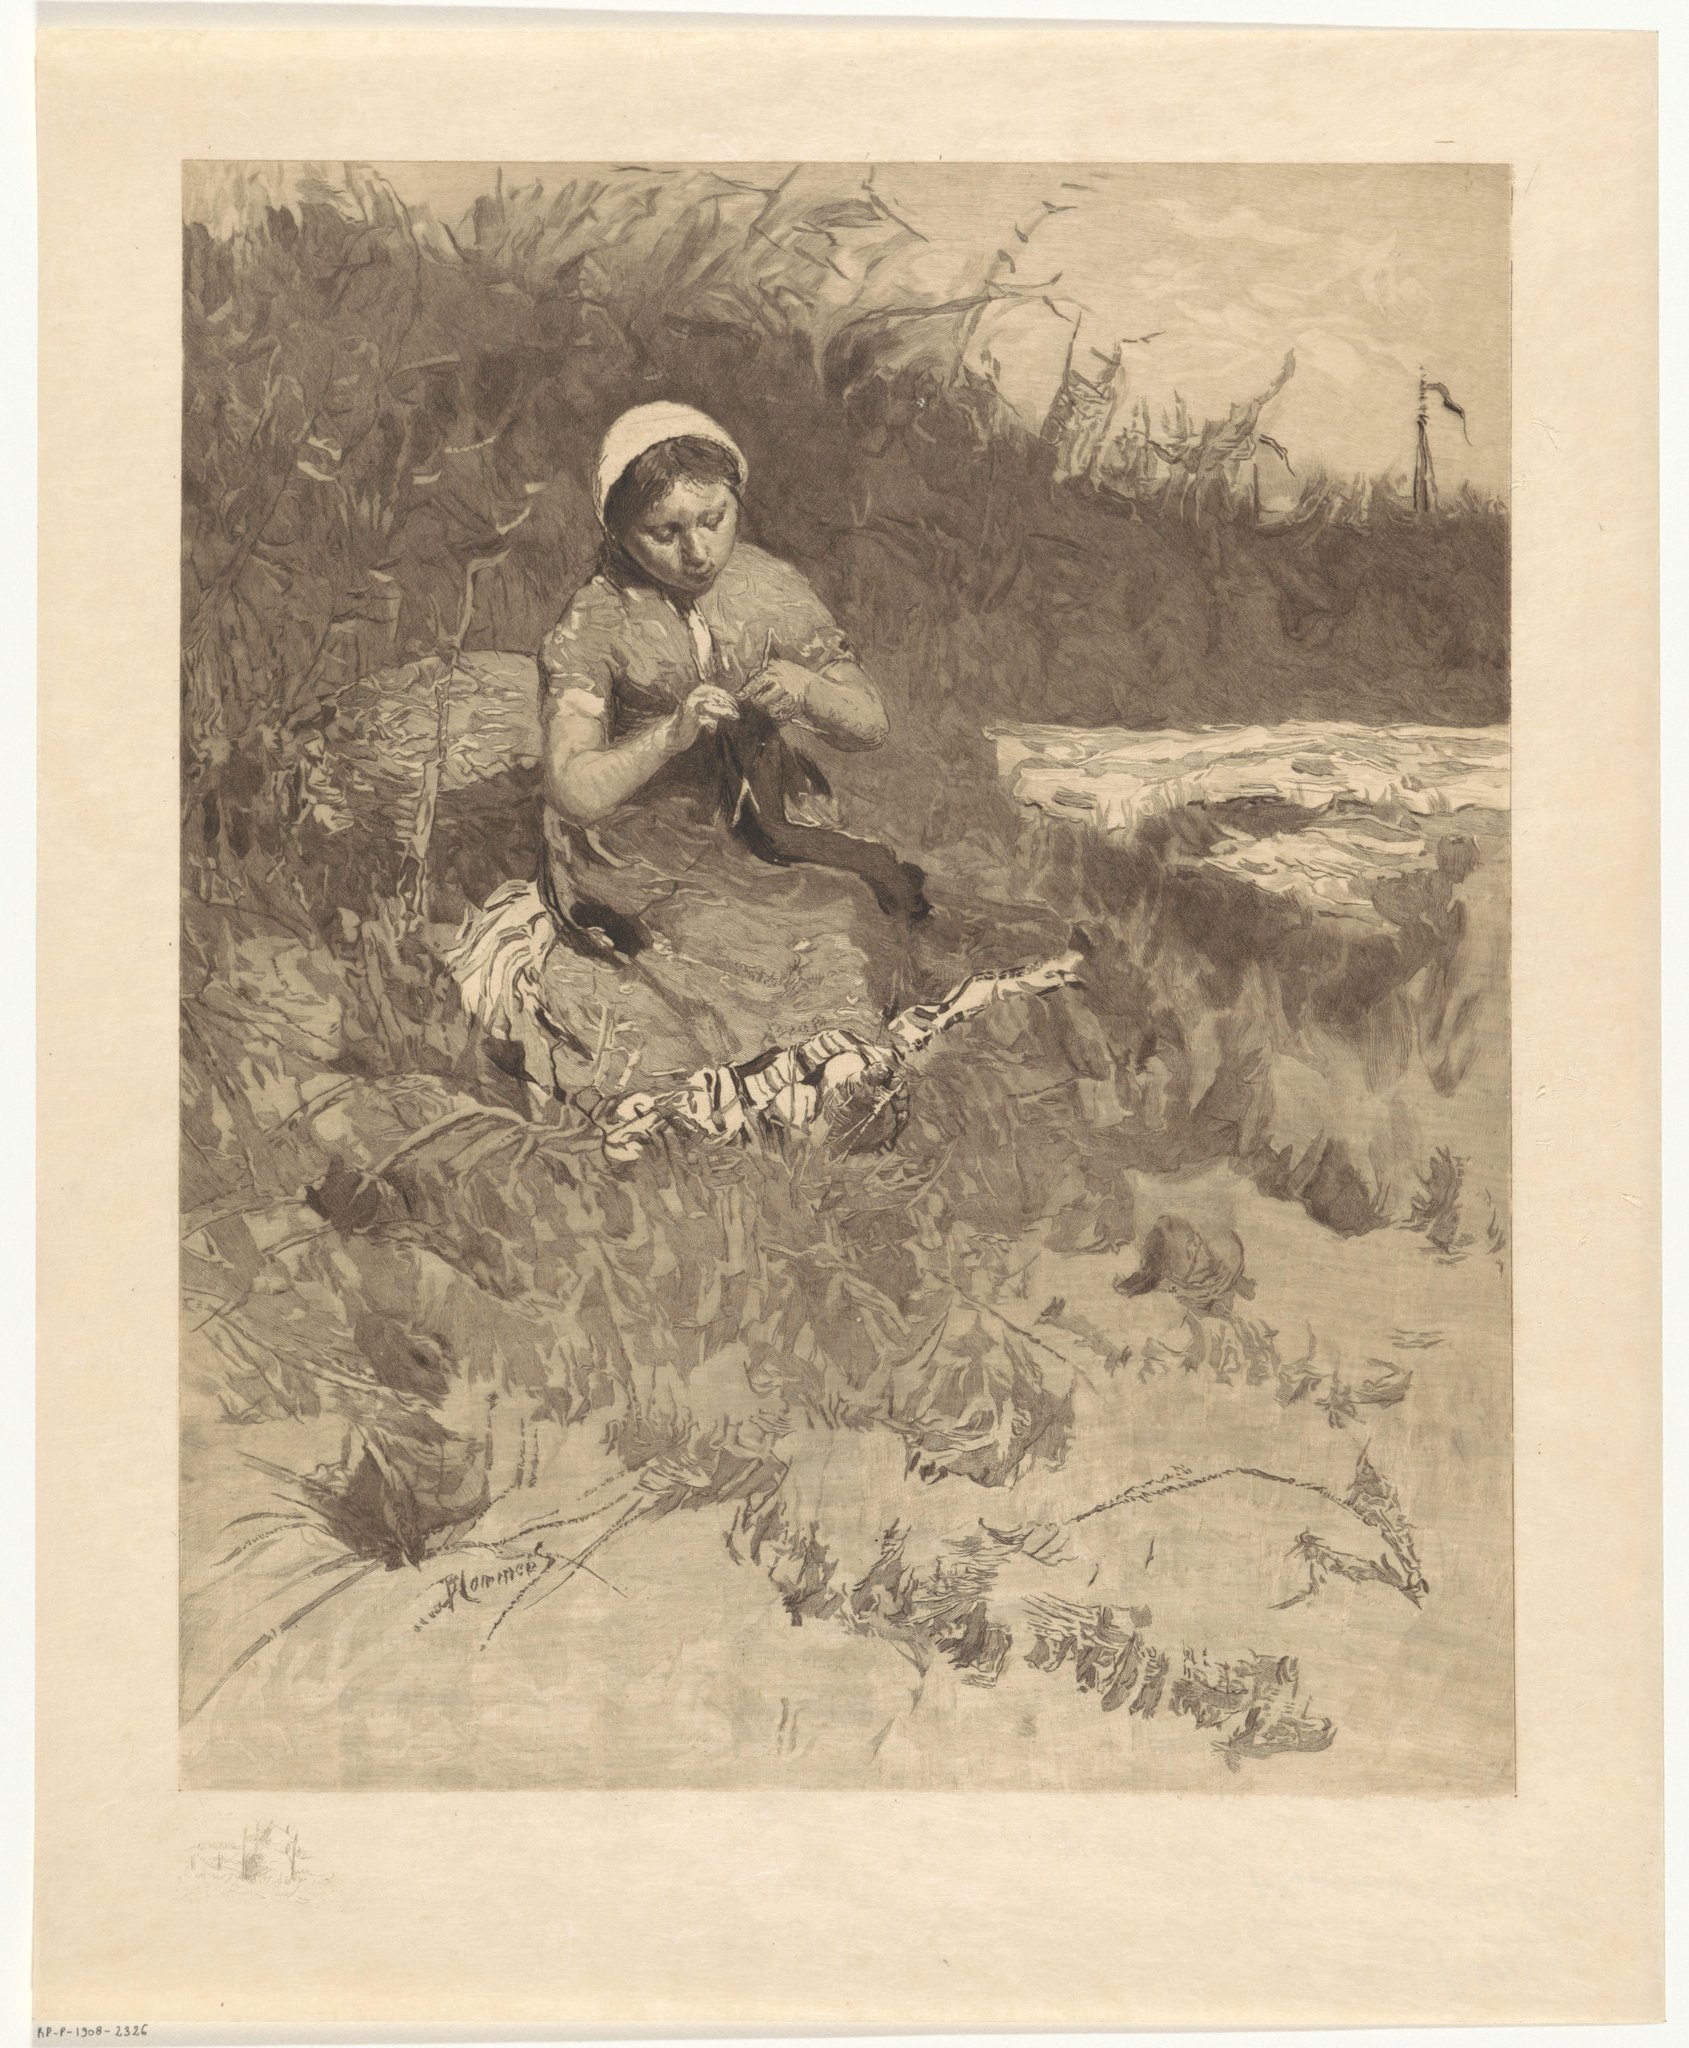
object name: print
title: Breistertje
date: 1894-1908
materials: paper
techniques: etching, intaglio, roulette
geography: netherlands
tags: dune coast, knitting, hay-stack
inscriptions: collector's mark: Lugt 2228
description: Duinlandschap waarin een meisje zit te breien. In de marge een hooiberg.